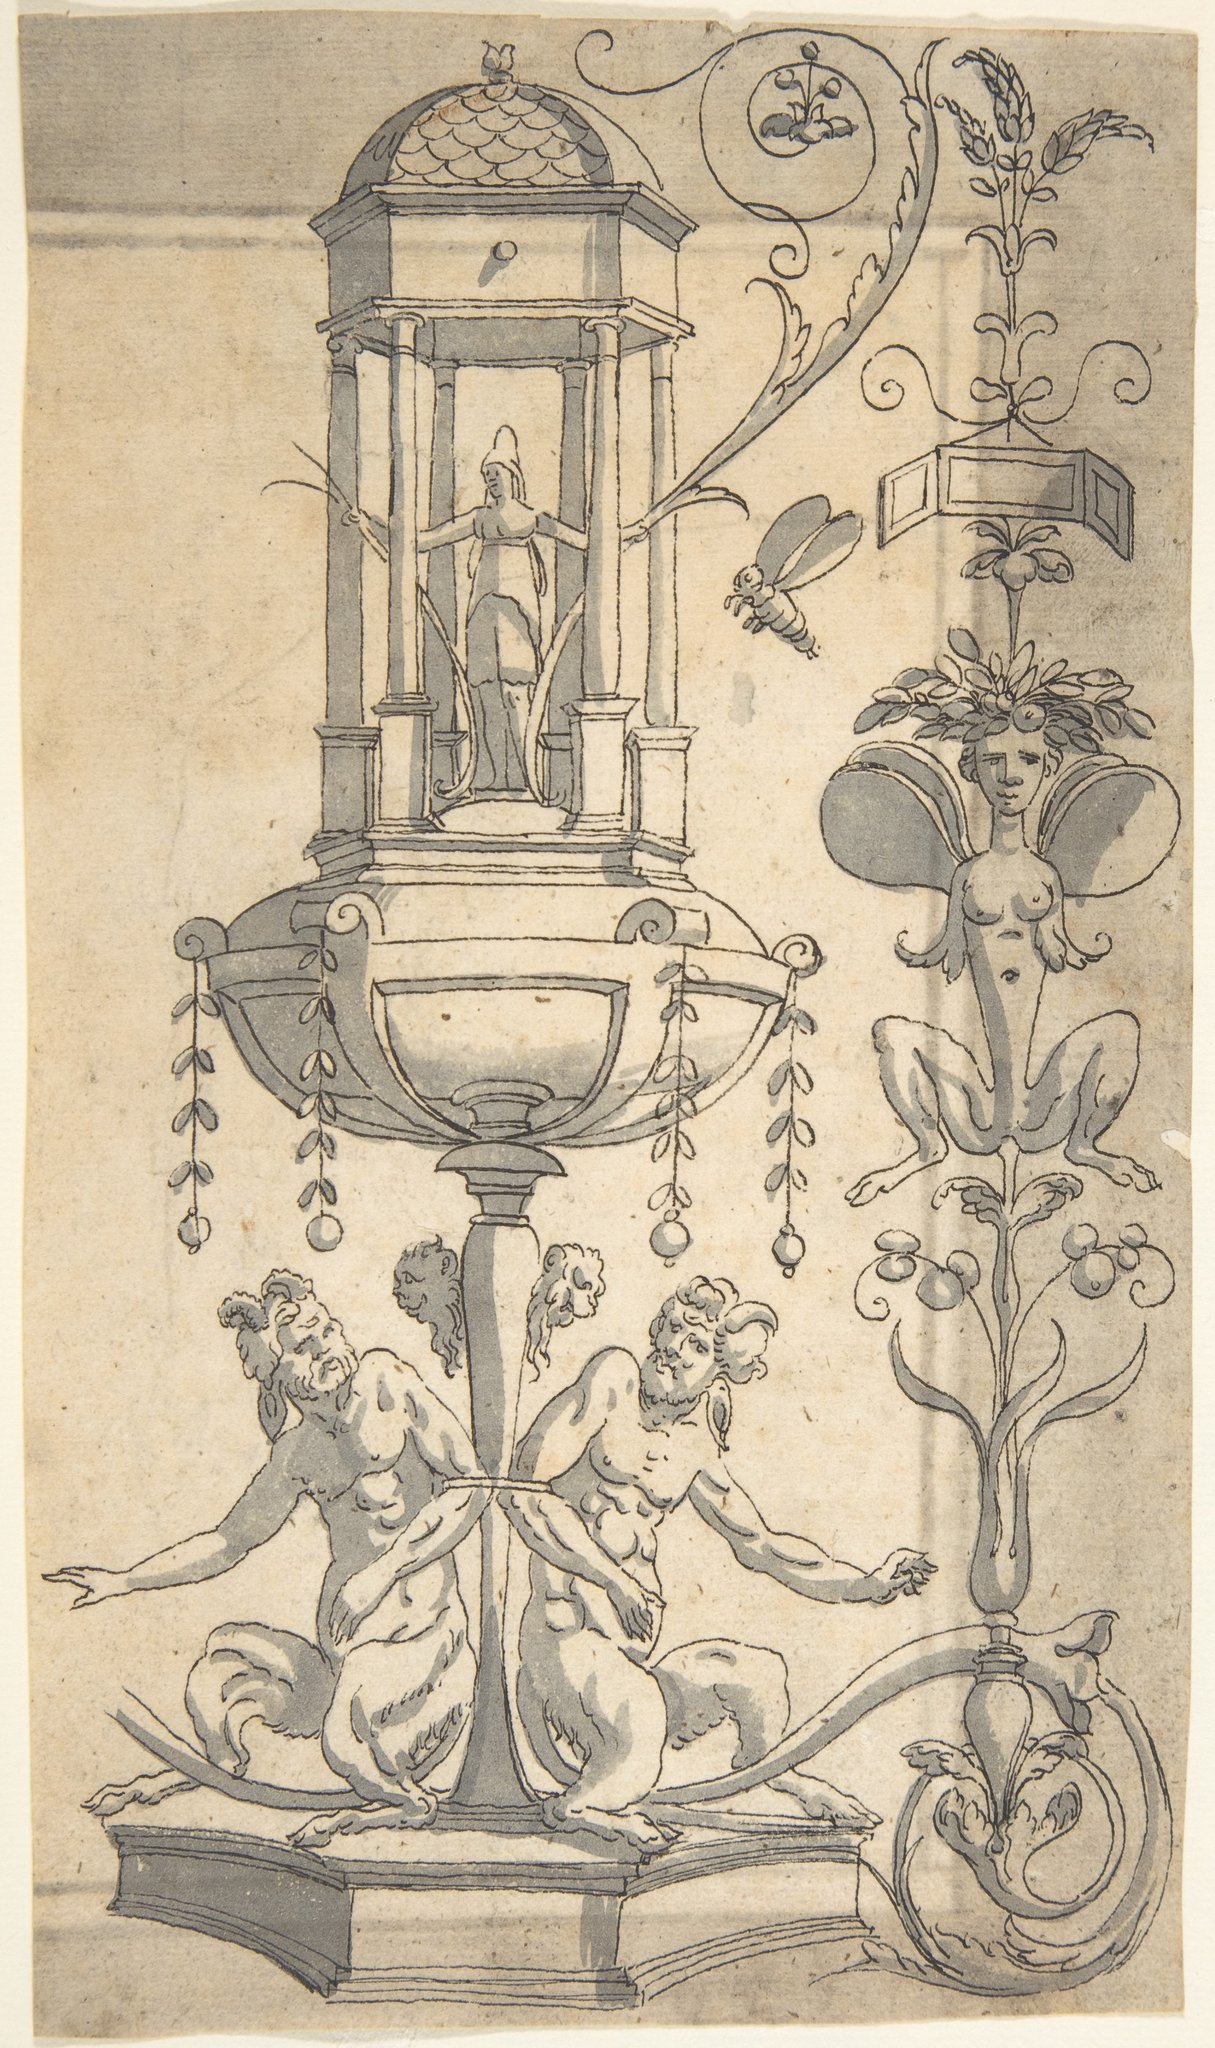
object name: ornament architecture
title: Candelabra Grotesque with an Hexagonal Pavillion on a Foot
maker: anonymous, italian, 16th century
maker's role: artist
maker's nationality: italian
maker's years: 1500-1600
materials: ink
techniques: brush, pen, wash